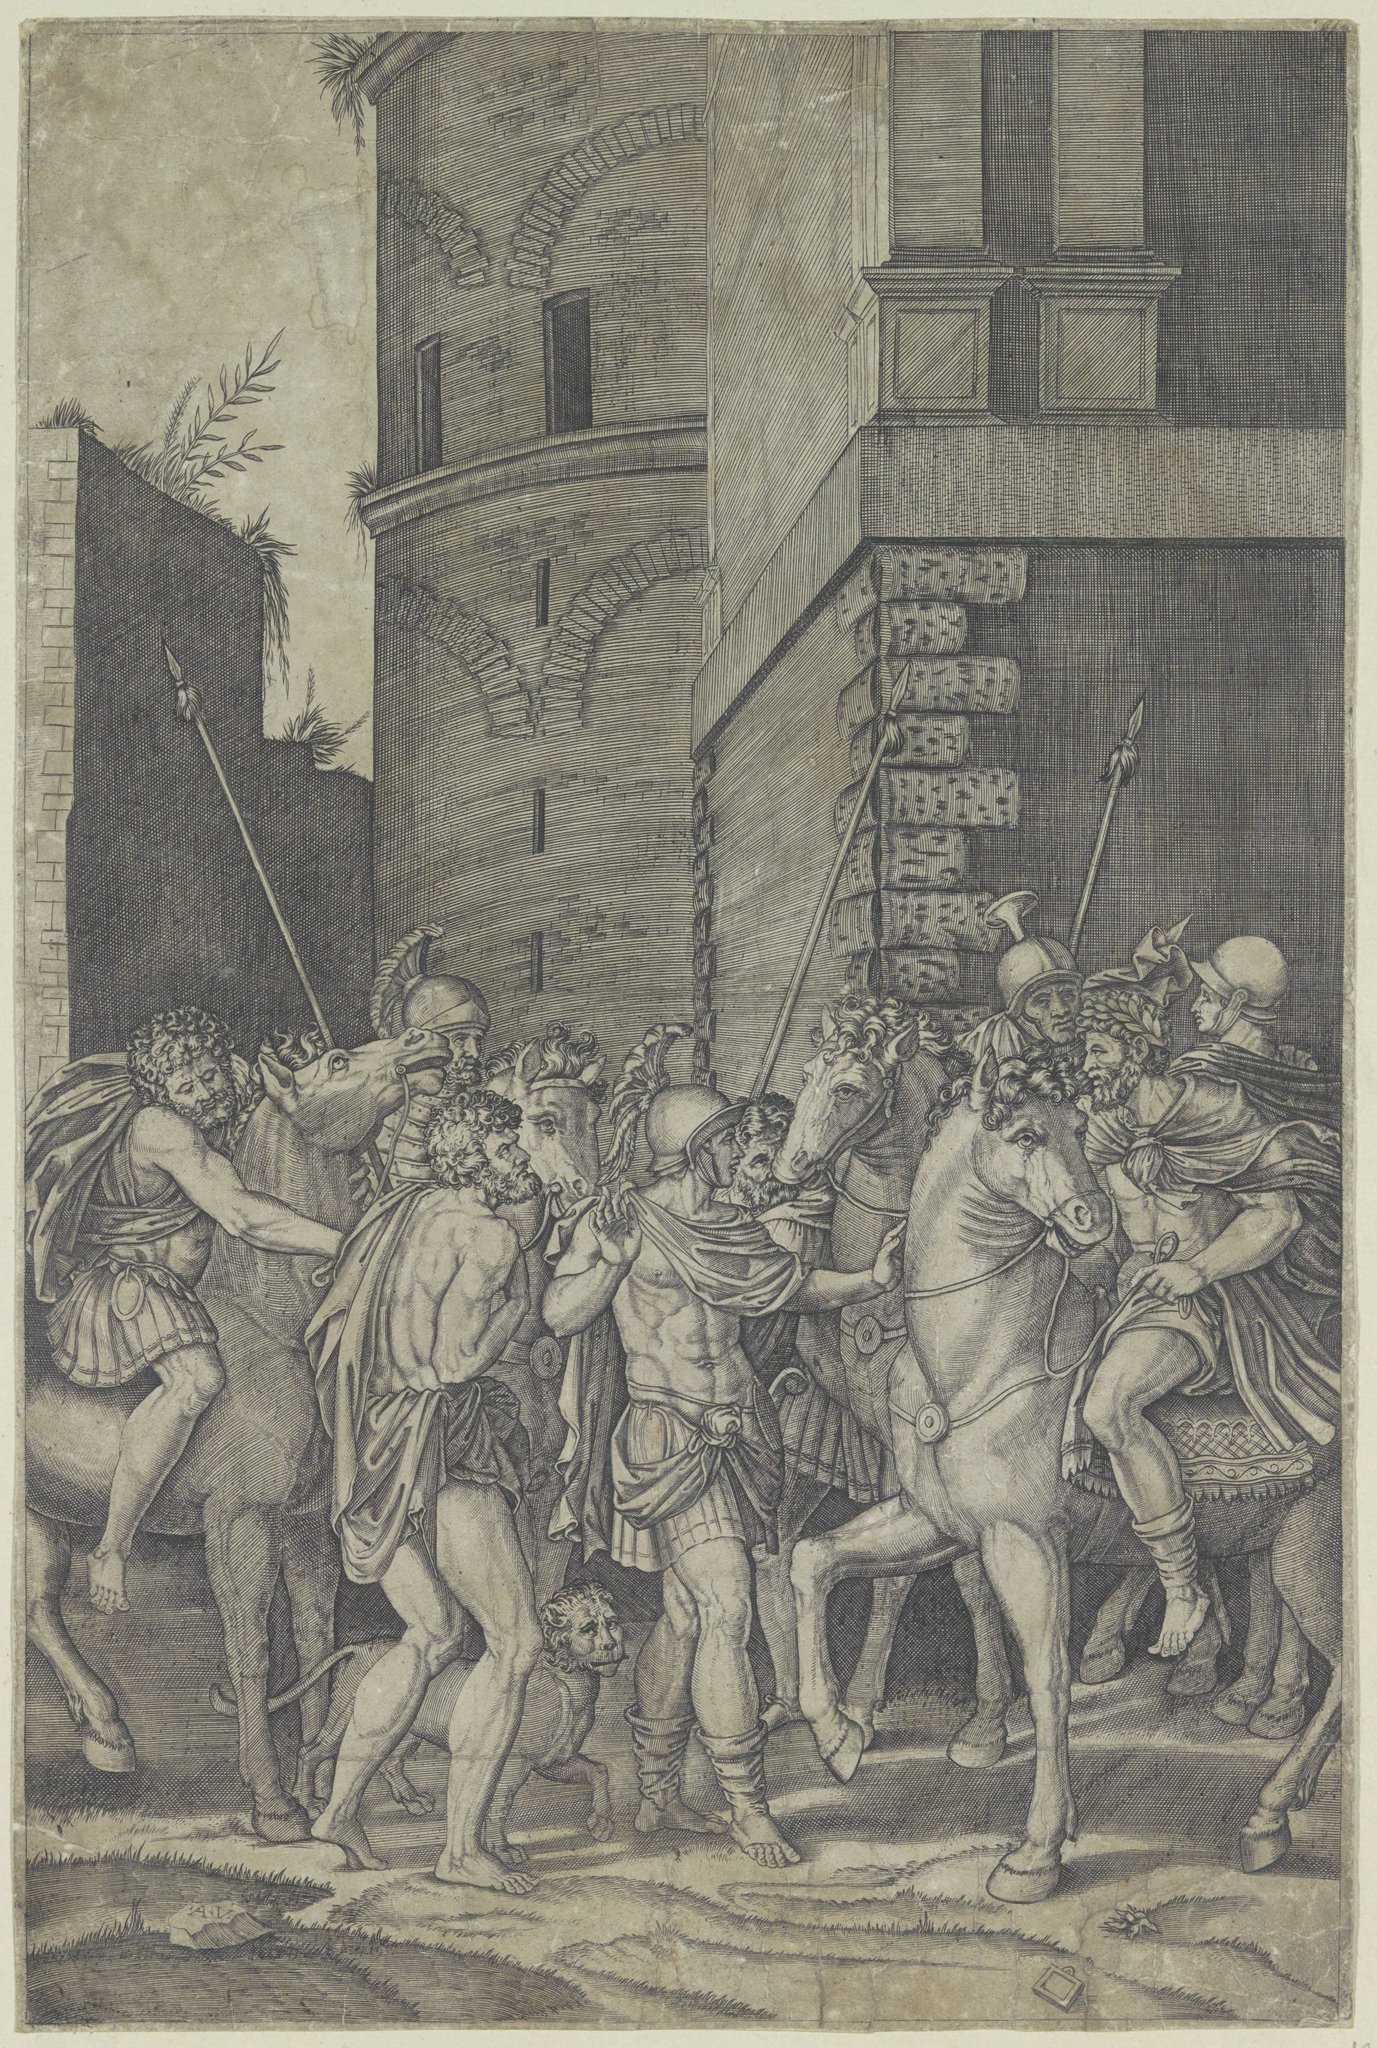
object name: print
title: Hadrianus ontmoet Androclus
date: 1500-1536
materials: paper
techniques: engraving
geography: italy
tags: androclus, when thrown to the lions in the arena, is not harmed, because he is recognized by the lion, whose paw he had cured (androclus is subsequently pardoned by the emperor hadrian)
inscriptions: collector's mark: Lugt 240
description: De Romeinse keizer Hadrianus, te paard, ontmoet Androclus die links staat te midden van Romeinse soldaten. Naast Androclus de leeuw uit wiens poot hij een doorn verwijderde.